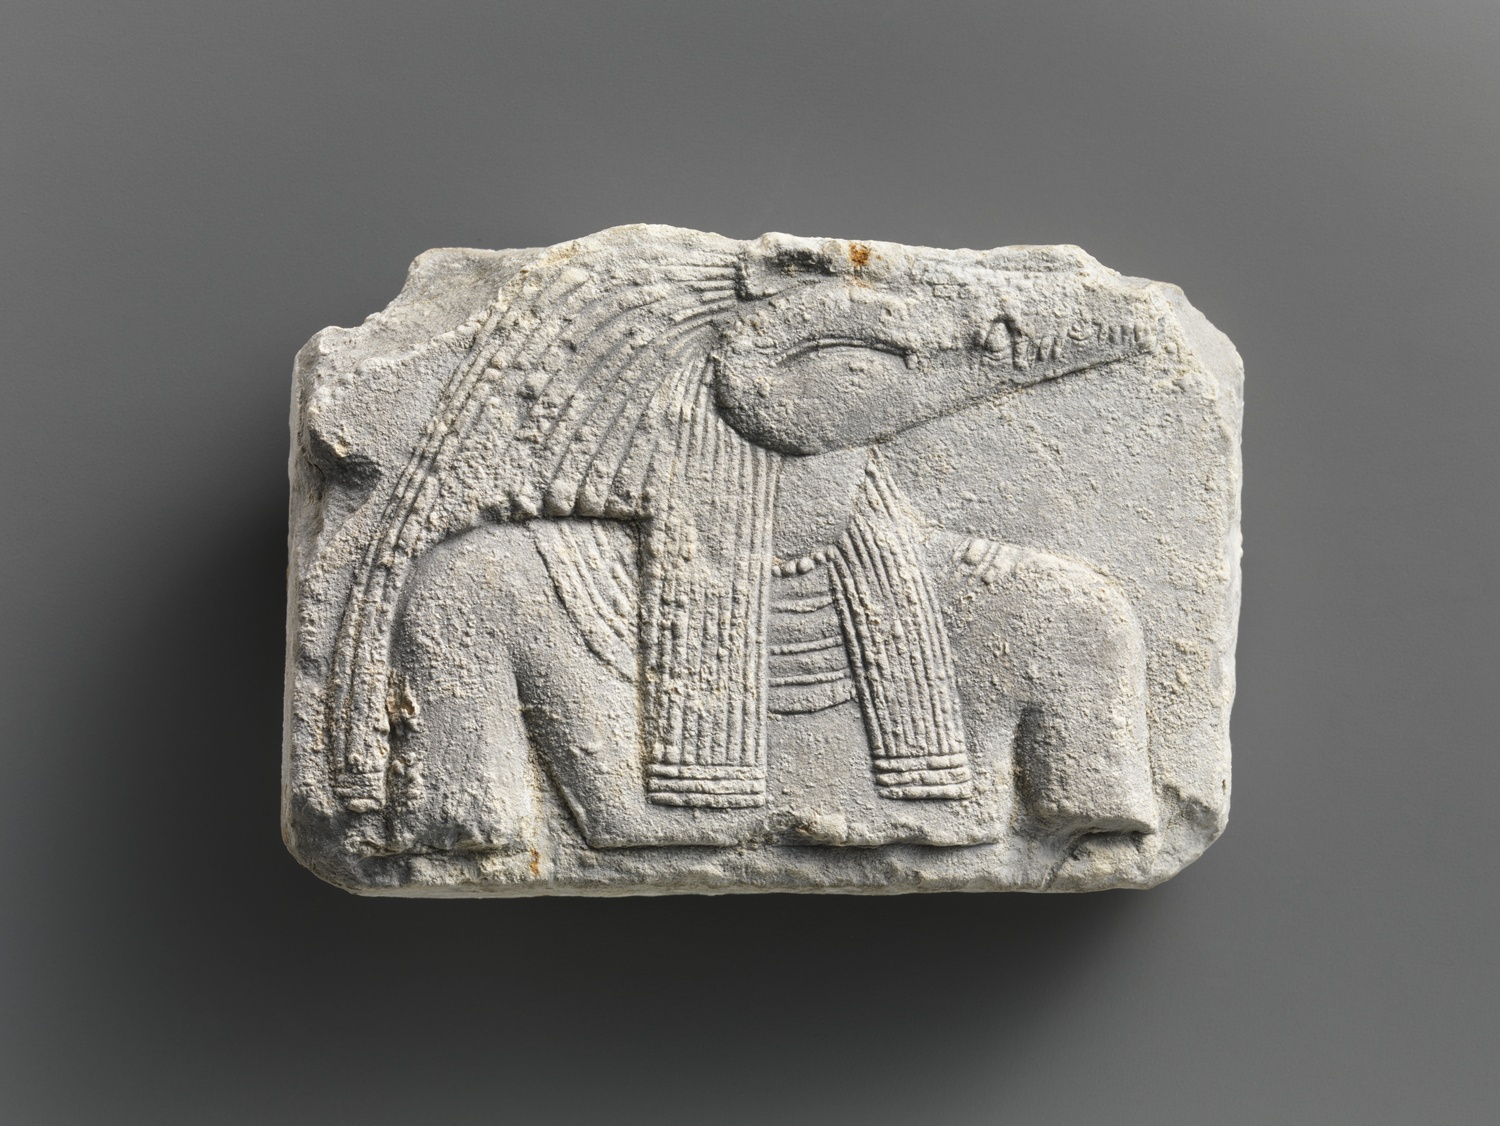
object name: sculptor's model votive, upper part of crocodile headed god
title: Relief plaque, upper part of crocodile-headed god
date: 400-30 BCE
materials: limestone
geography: egypt